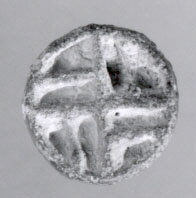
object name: stamp seal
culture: bactria-margiana archaeological complex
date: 2333-1668 BCE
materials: copper alloy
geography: bactria-margiana